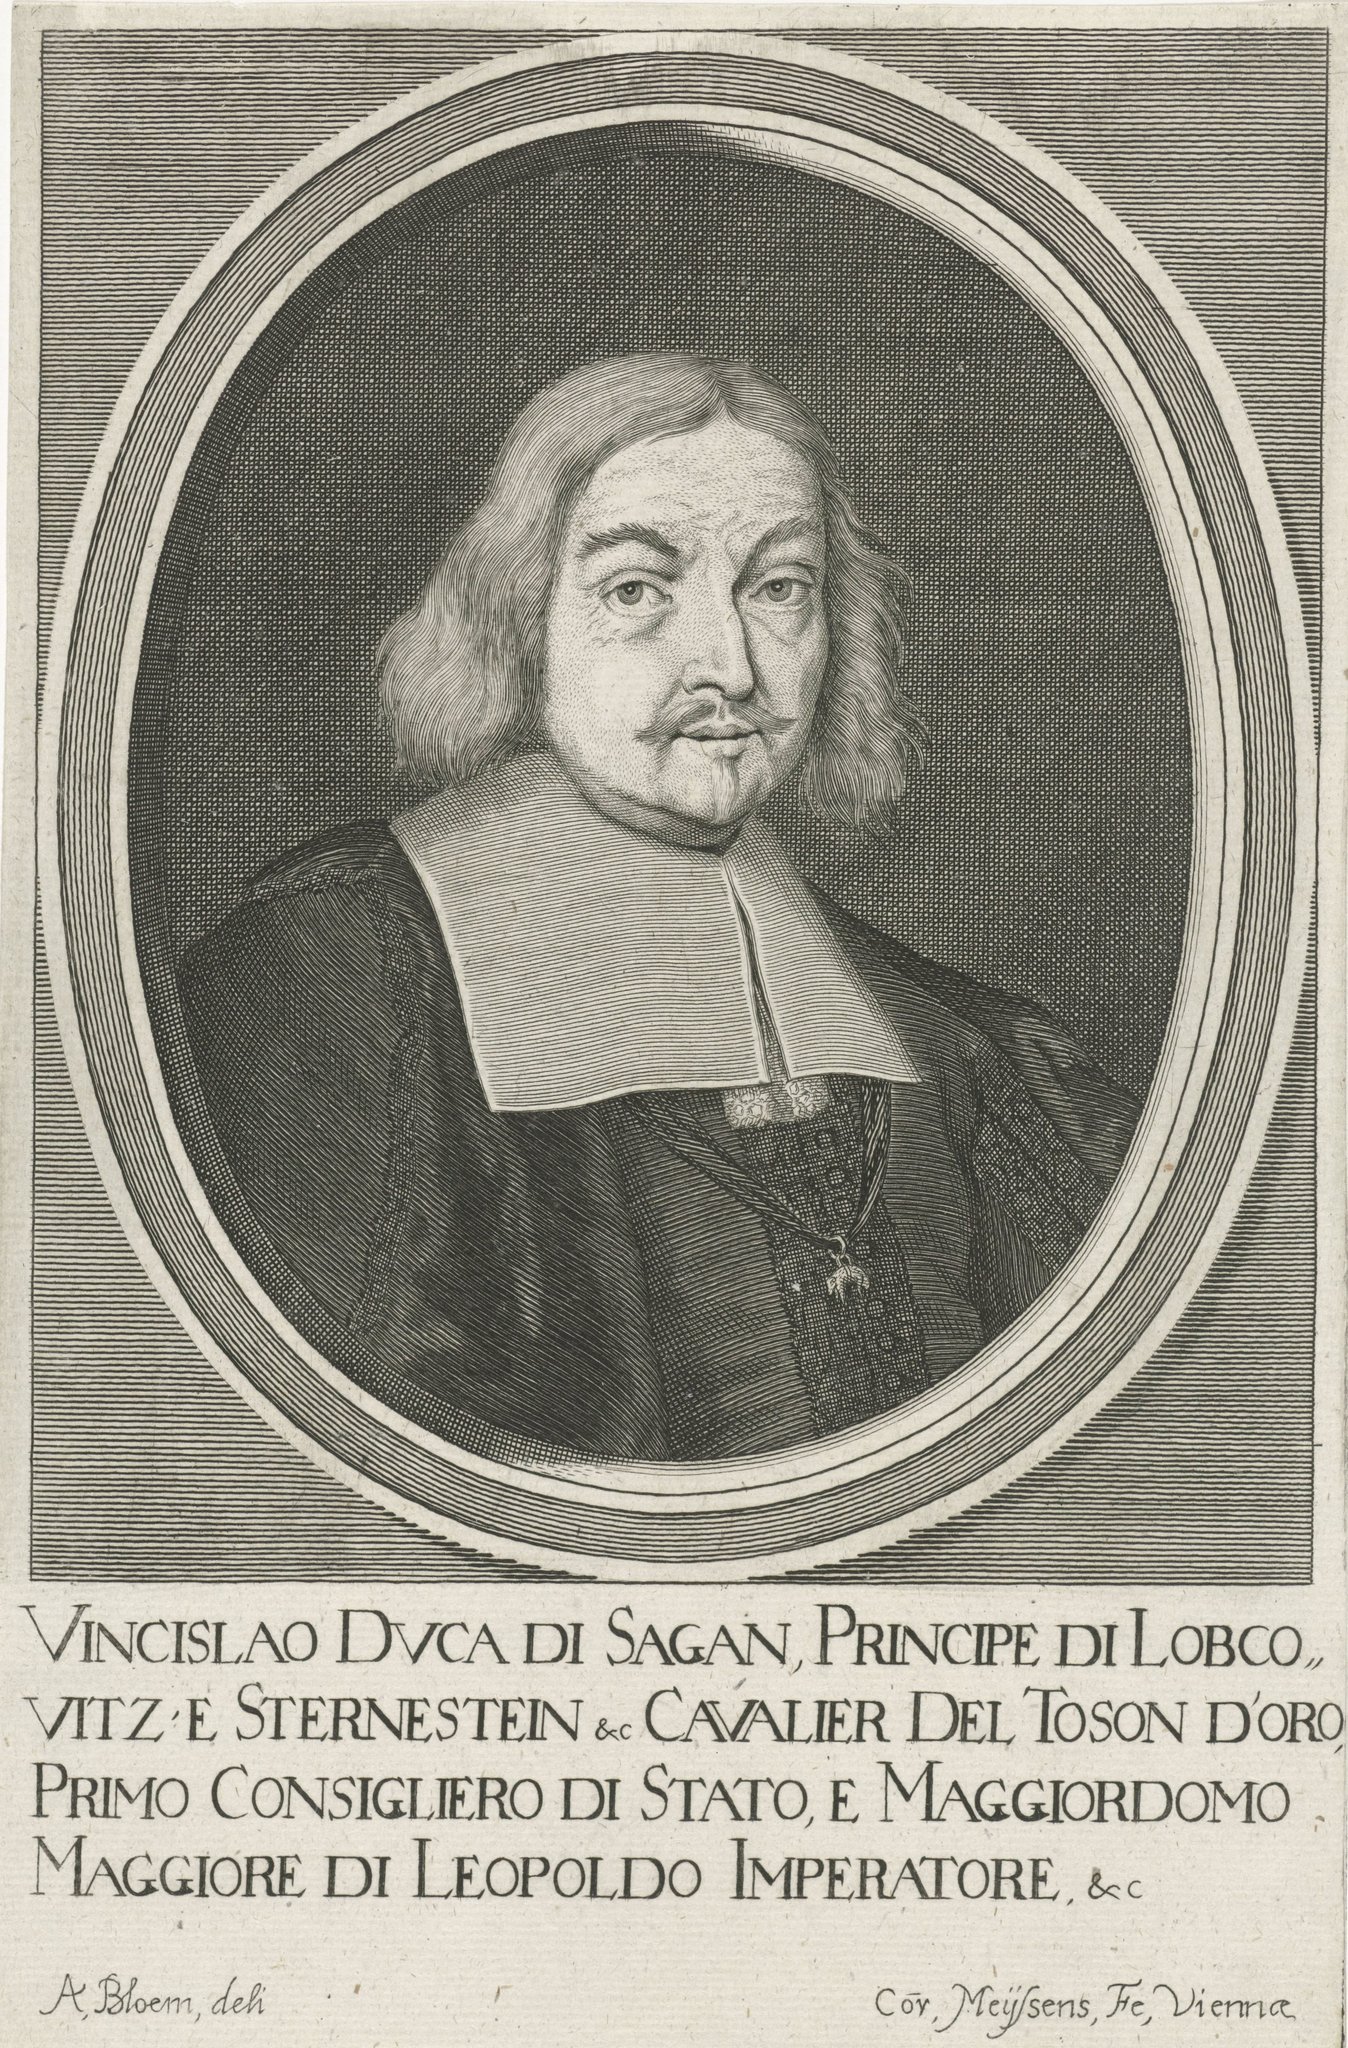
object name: book illustration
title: Portret van Wenzel Eusebius von Lobkowitz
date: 1670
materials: paper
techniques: engraving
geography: vienna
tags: knighthood order of the golden fleece - insignia of a knighthood order, e.g.: badge, chain (with name of order)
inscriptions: collector's mark: Lugt 2228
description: Portret van Wenzel Eusebius von Lobkowitz, hertog van Sagan en Raudnitz, graaf van Sternstein. Om zijn hals een lint met het ordeteken van de Orde van het Gulden Vlies. Onderaan in de marge zijn titels in het Italiaans.